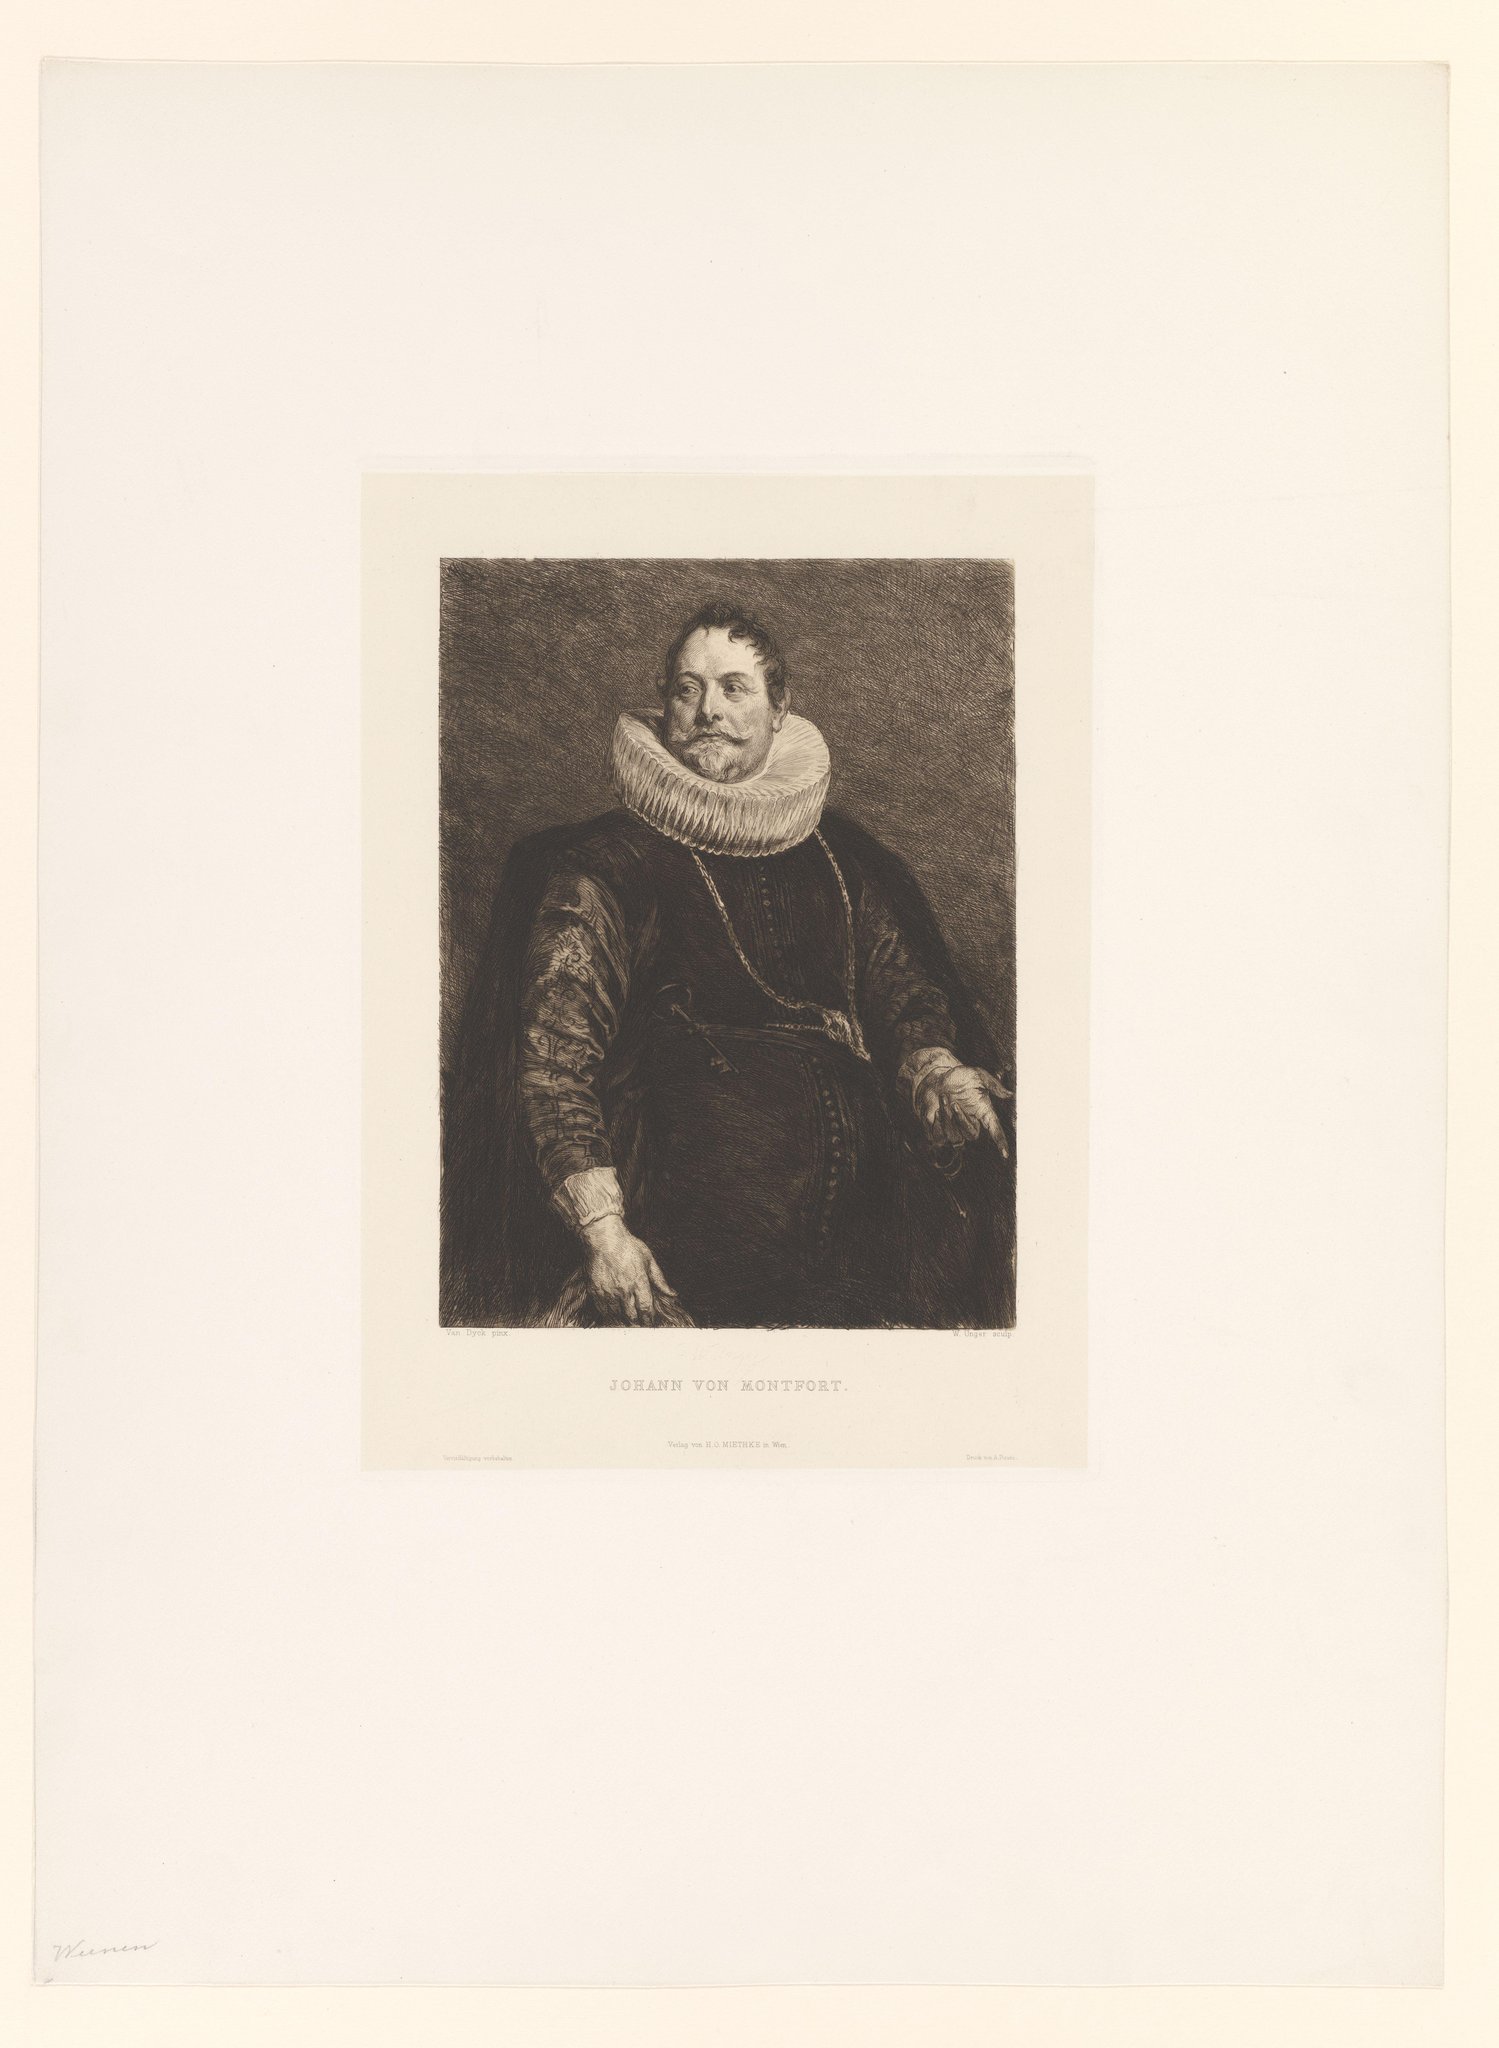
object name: print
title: Johann von Montfort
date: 1861-1889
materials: paper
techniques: etching, intaglio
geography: vienna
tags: brussels, historical persons, key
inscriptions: collector's mark: Lugt 2228